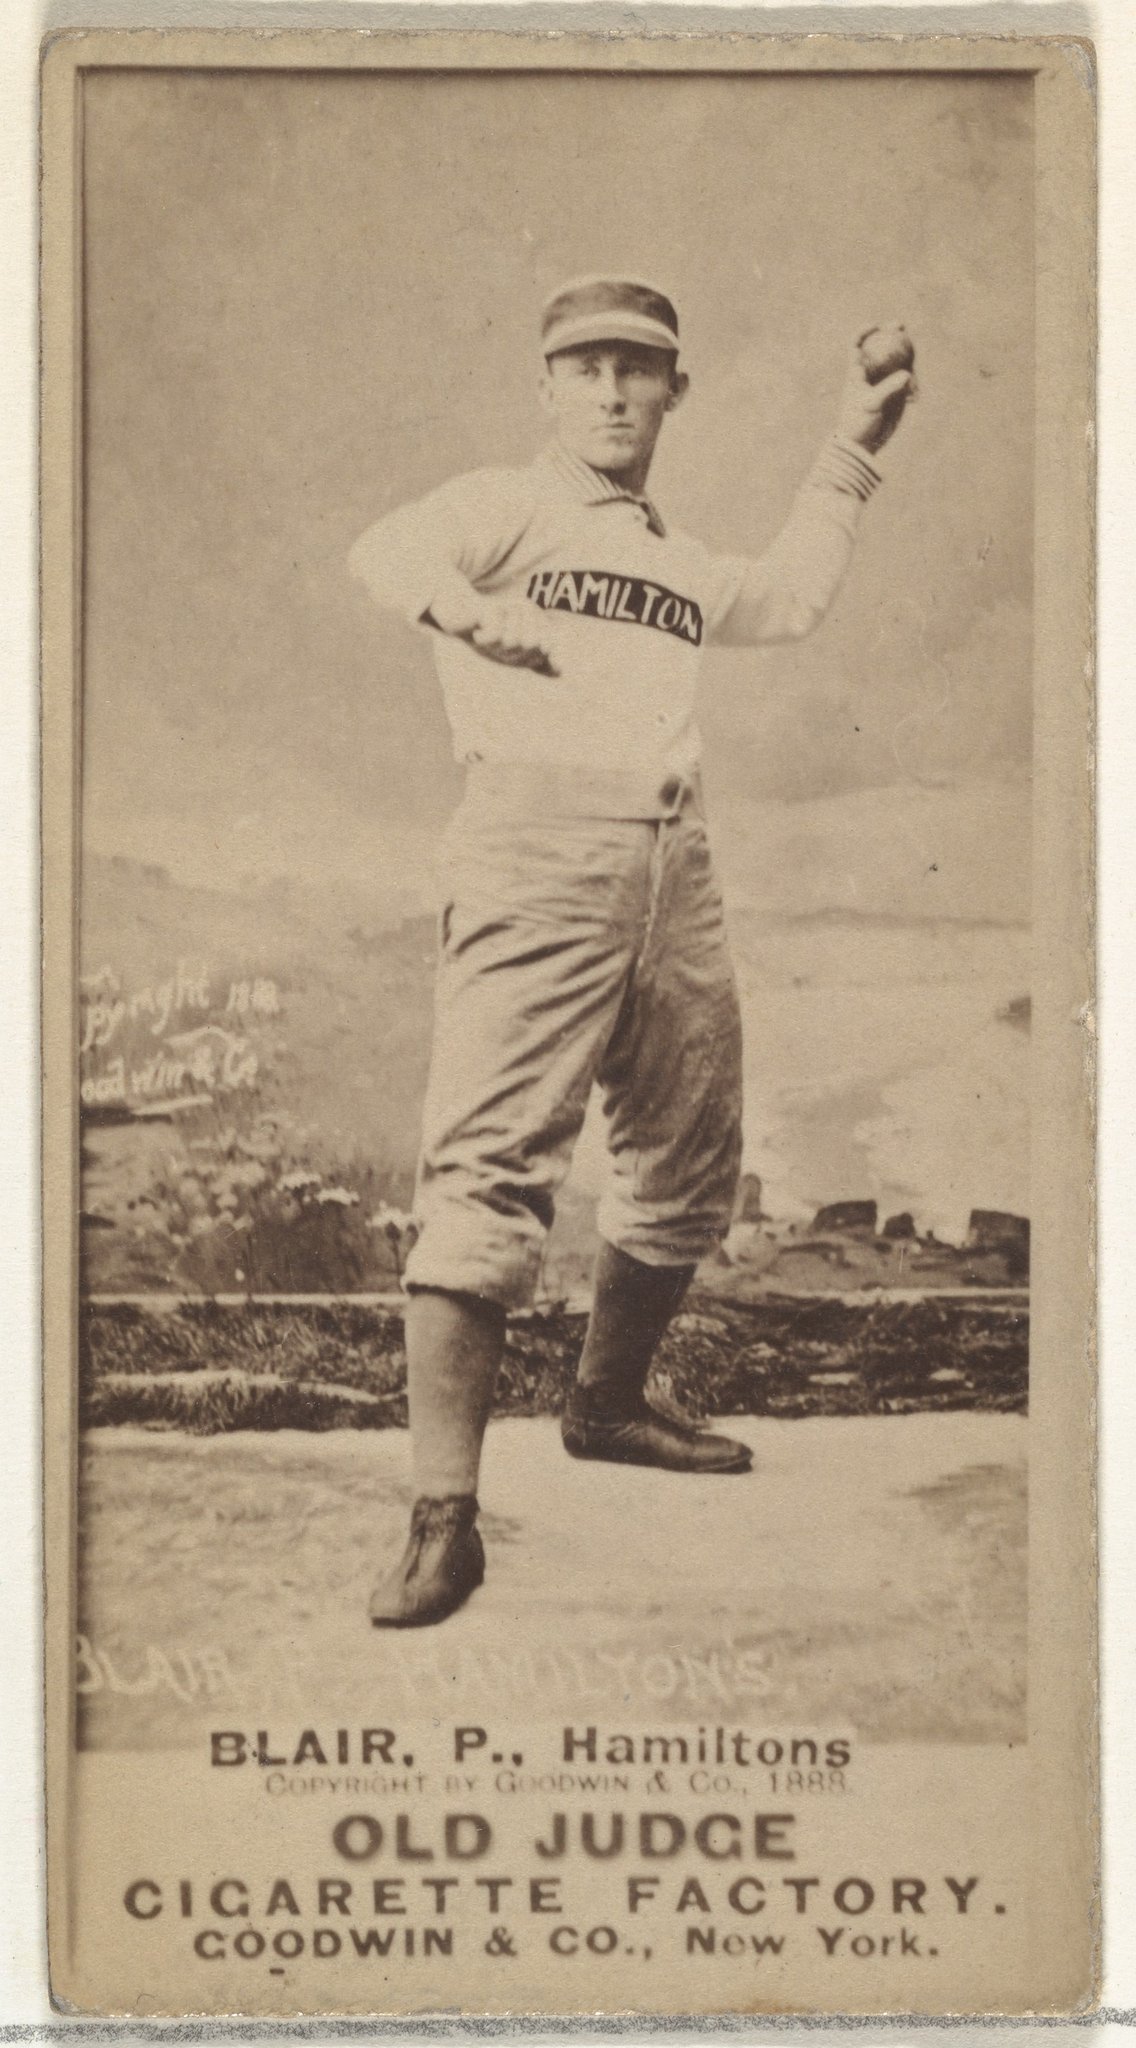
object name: baseball card, photograph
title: William Ellsworth "Bill" Blair, Pitcher, Hamilton Hams, from the Old Judge series (N172) for Old Judge Cigarettes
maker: goodwin & company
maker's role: publisher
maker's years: 1850-1950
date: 1888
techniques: albumen silver print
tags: men,portraits,baseball,athletes